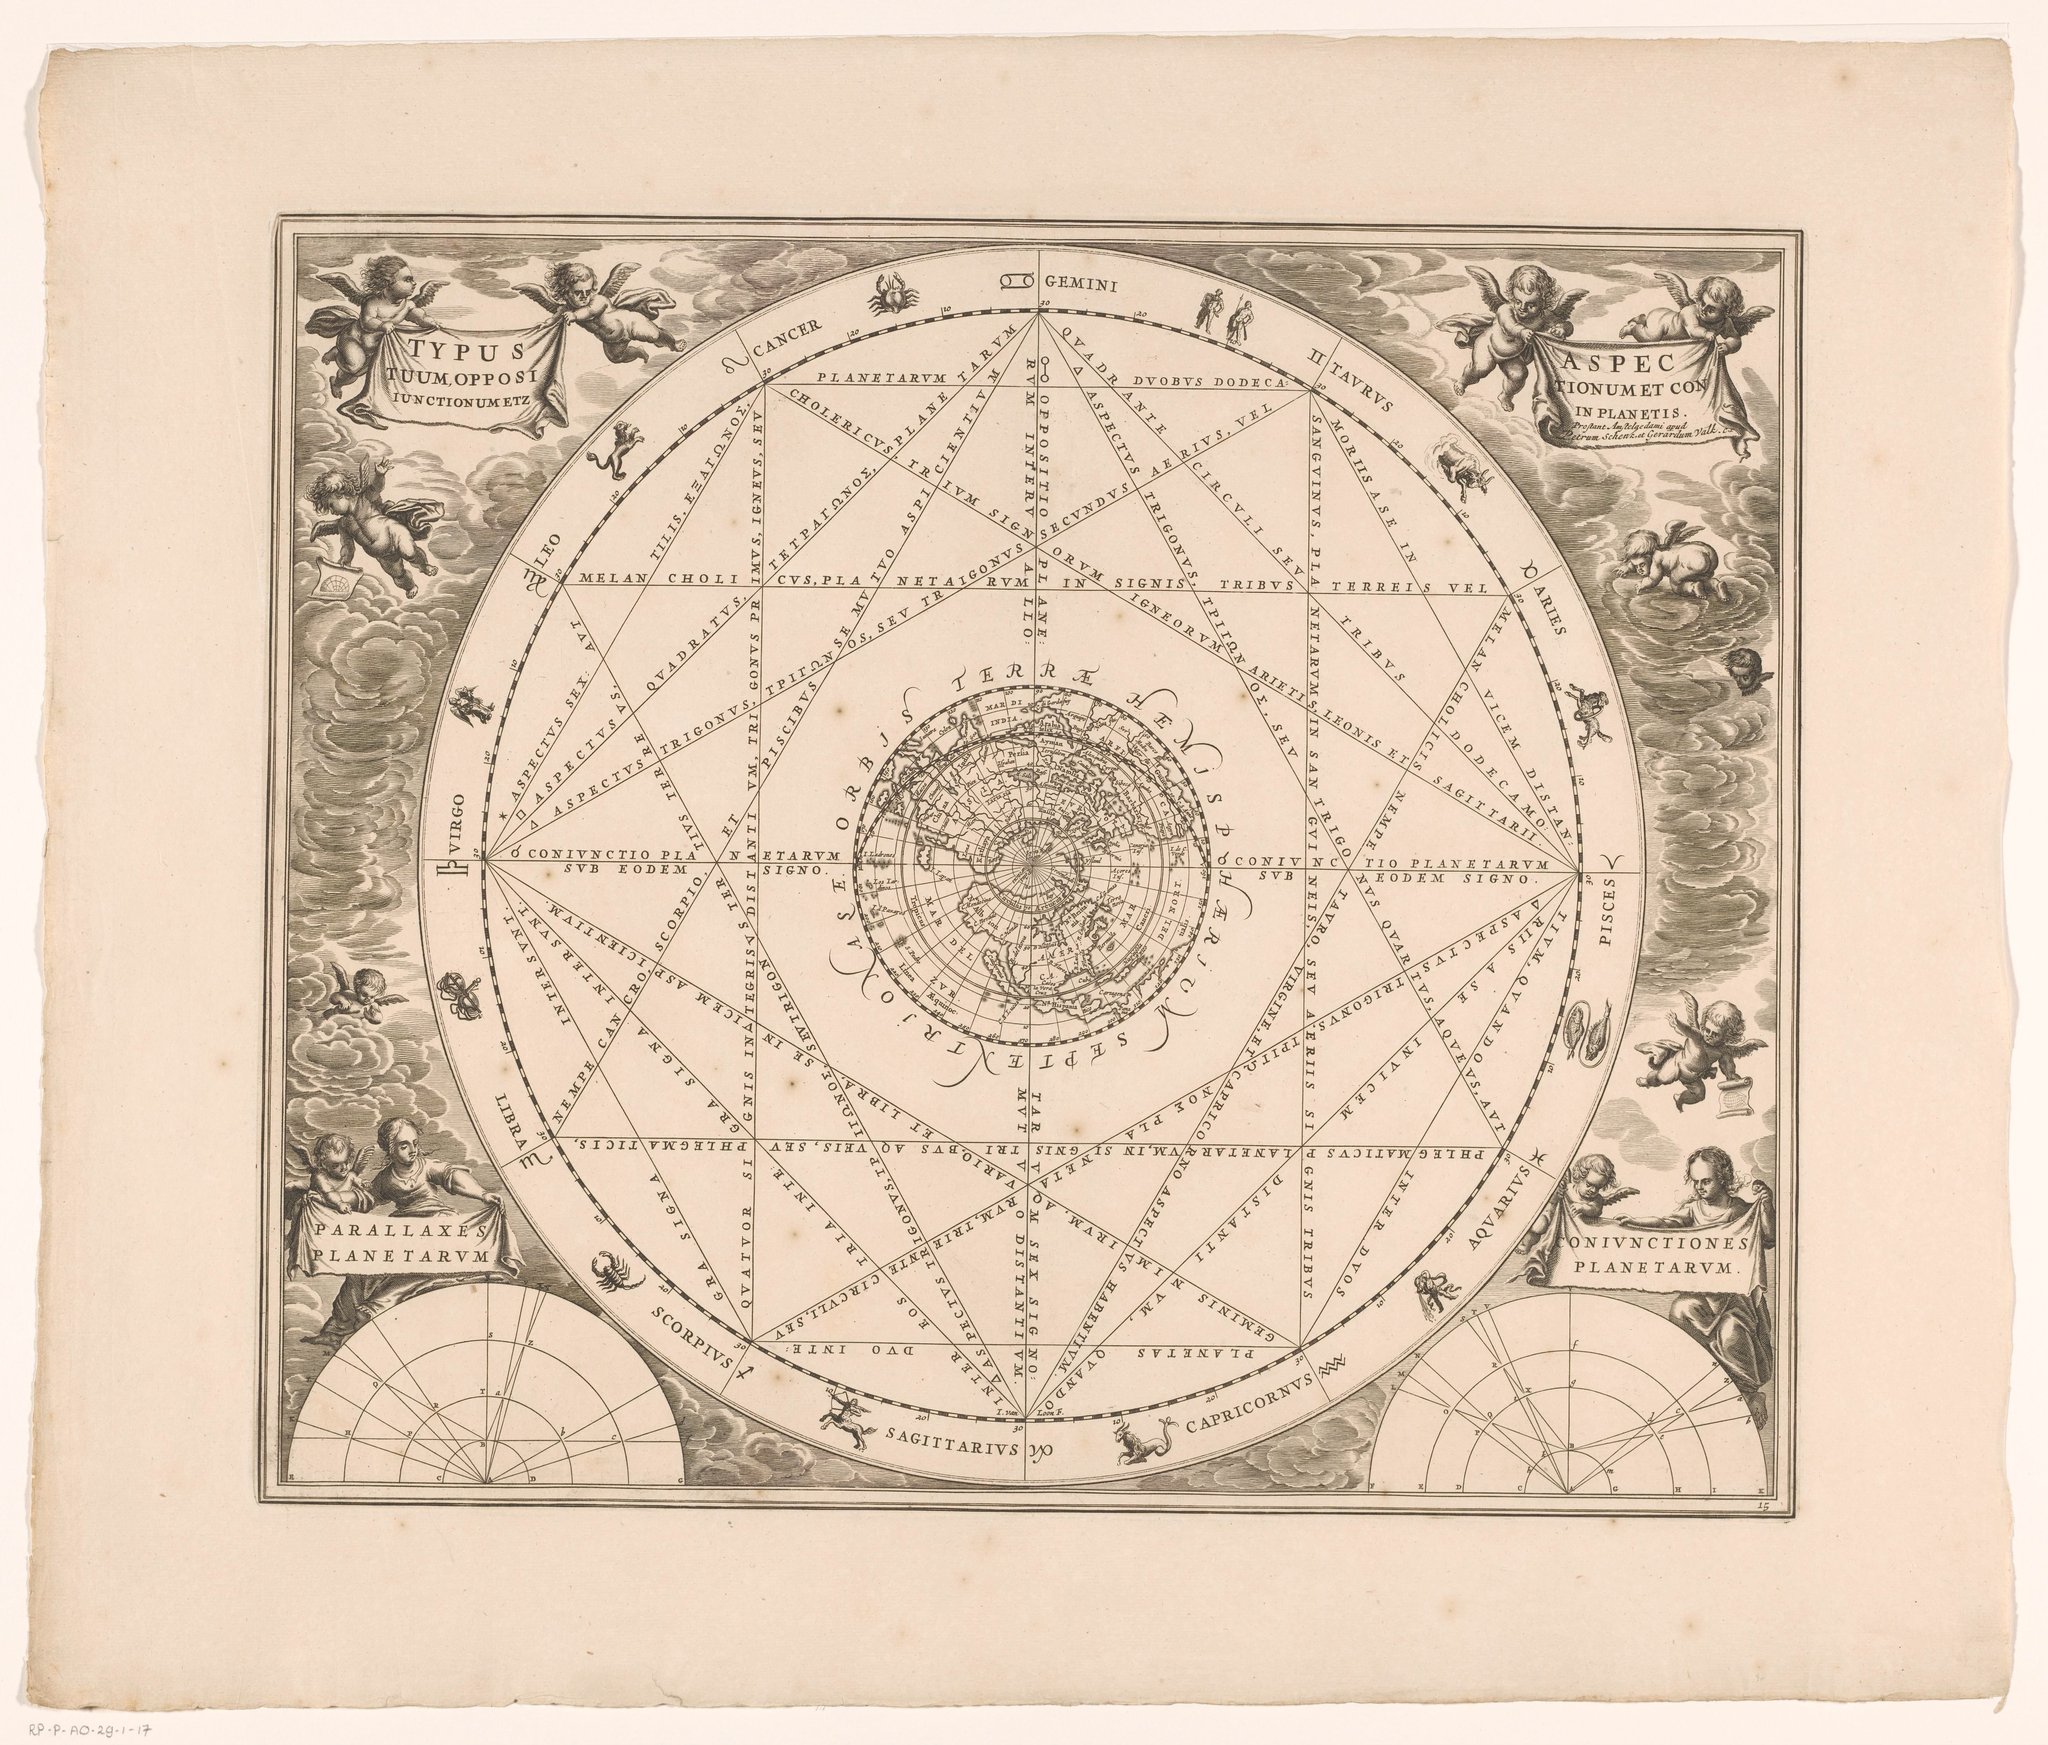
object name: print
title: Hemelkaart van het noordelijk halfrond met verbanden tussen de sterrenbeelden en de elementen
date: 1660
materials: paper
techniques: engraving, etching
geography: amsterdam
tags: the four elements, and ether, the fifth element, zodiac; the twelve zodiacal signs together, star-chart, star map, planets; planetary system, solar system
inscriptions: collector's mark: Lugt 2228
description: Prent ook gebruikt in: Cellarius, Andreas. Harmonia Macrocosmica seu Atlas Universalis et Novus. Amsterdam: Pieter Schenk (I) en Gerard Valck, 1708. Zie ook: Gent, Rob van. De hemelatlas van Andreas Cellarius: het meesterwerk van een vergeten Hollandse kosmograaf. In: Caert-Thresoor, jaargang 19, nr. 1, 2000.